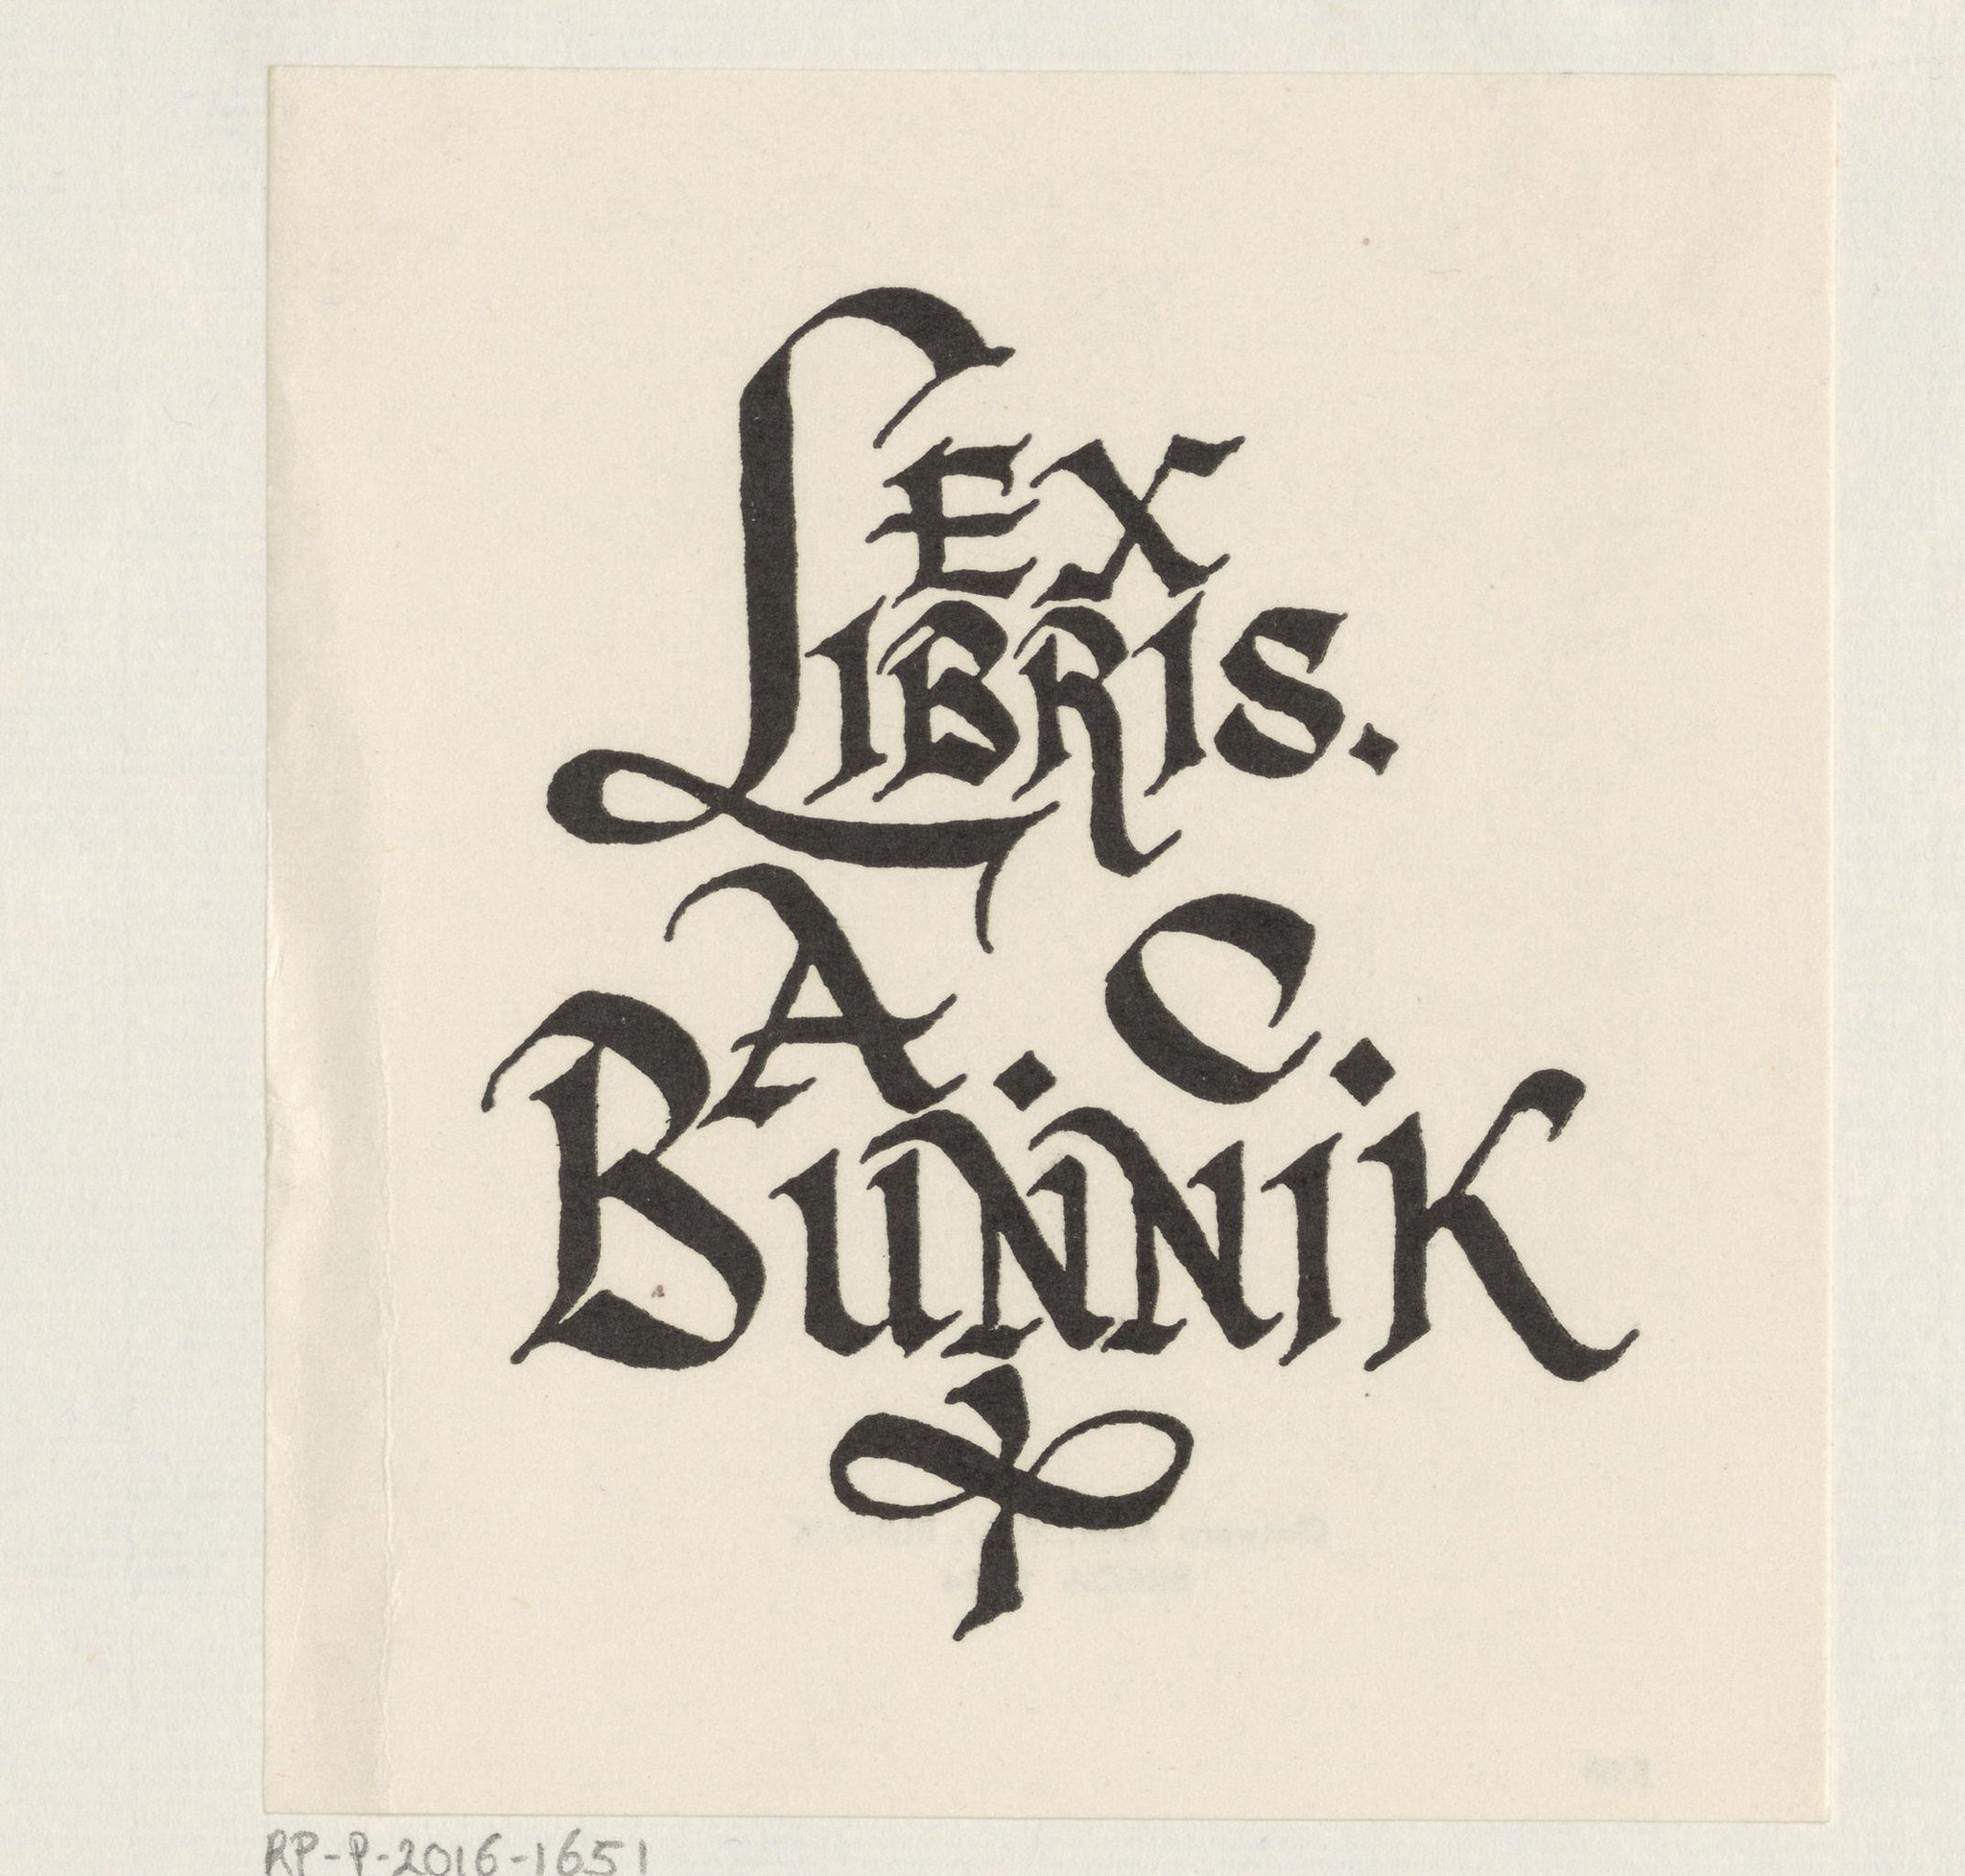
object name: bookplate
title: Ex libris van A.C. Bunnik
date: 1944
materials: paper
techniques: printing block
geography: breda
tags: calligraphy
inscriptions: workshop stamp: ‘Ontwerp Arch. W.J. Bunnik / Breda 1944’